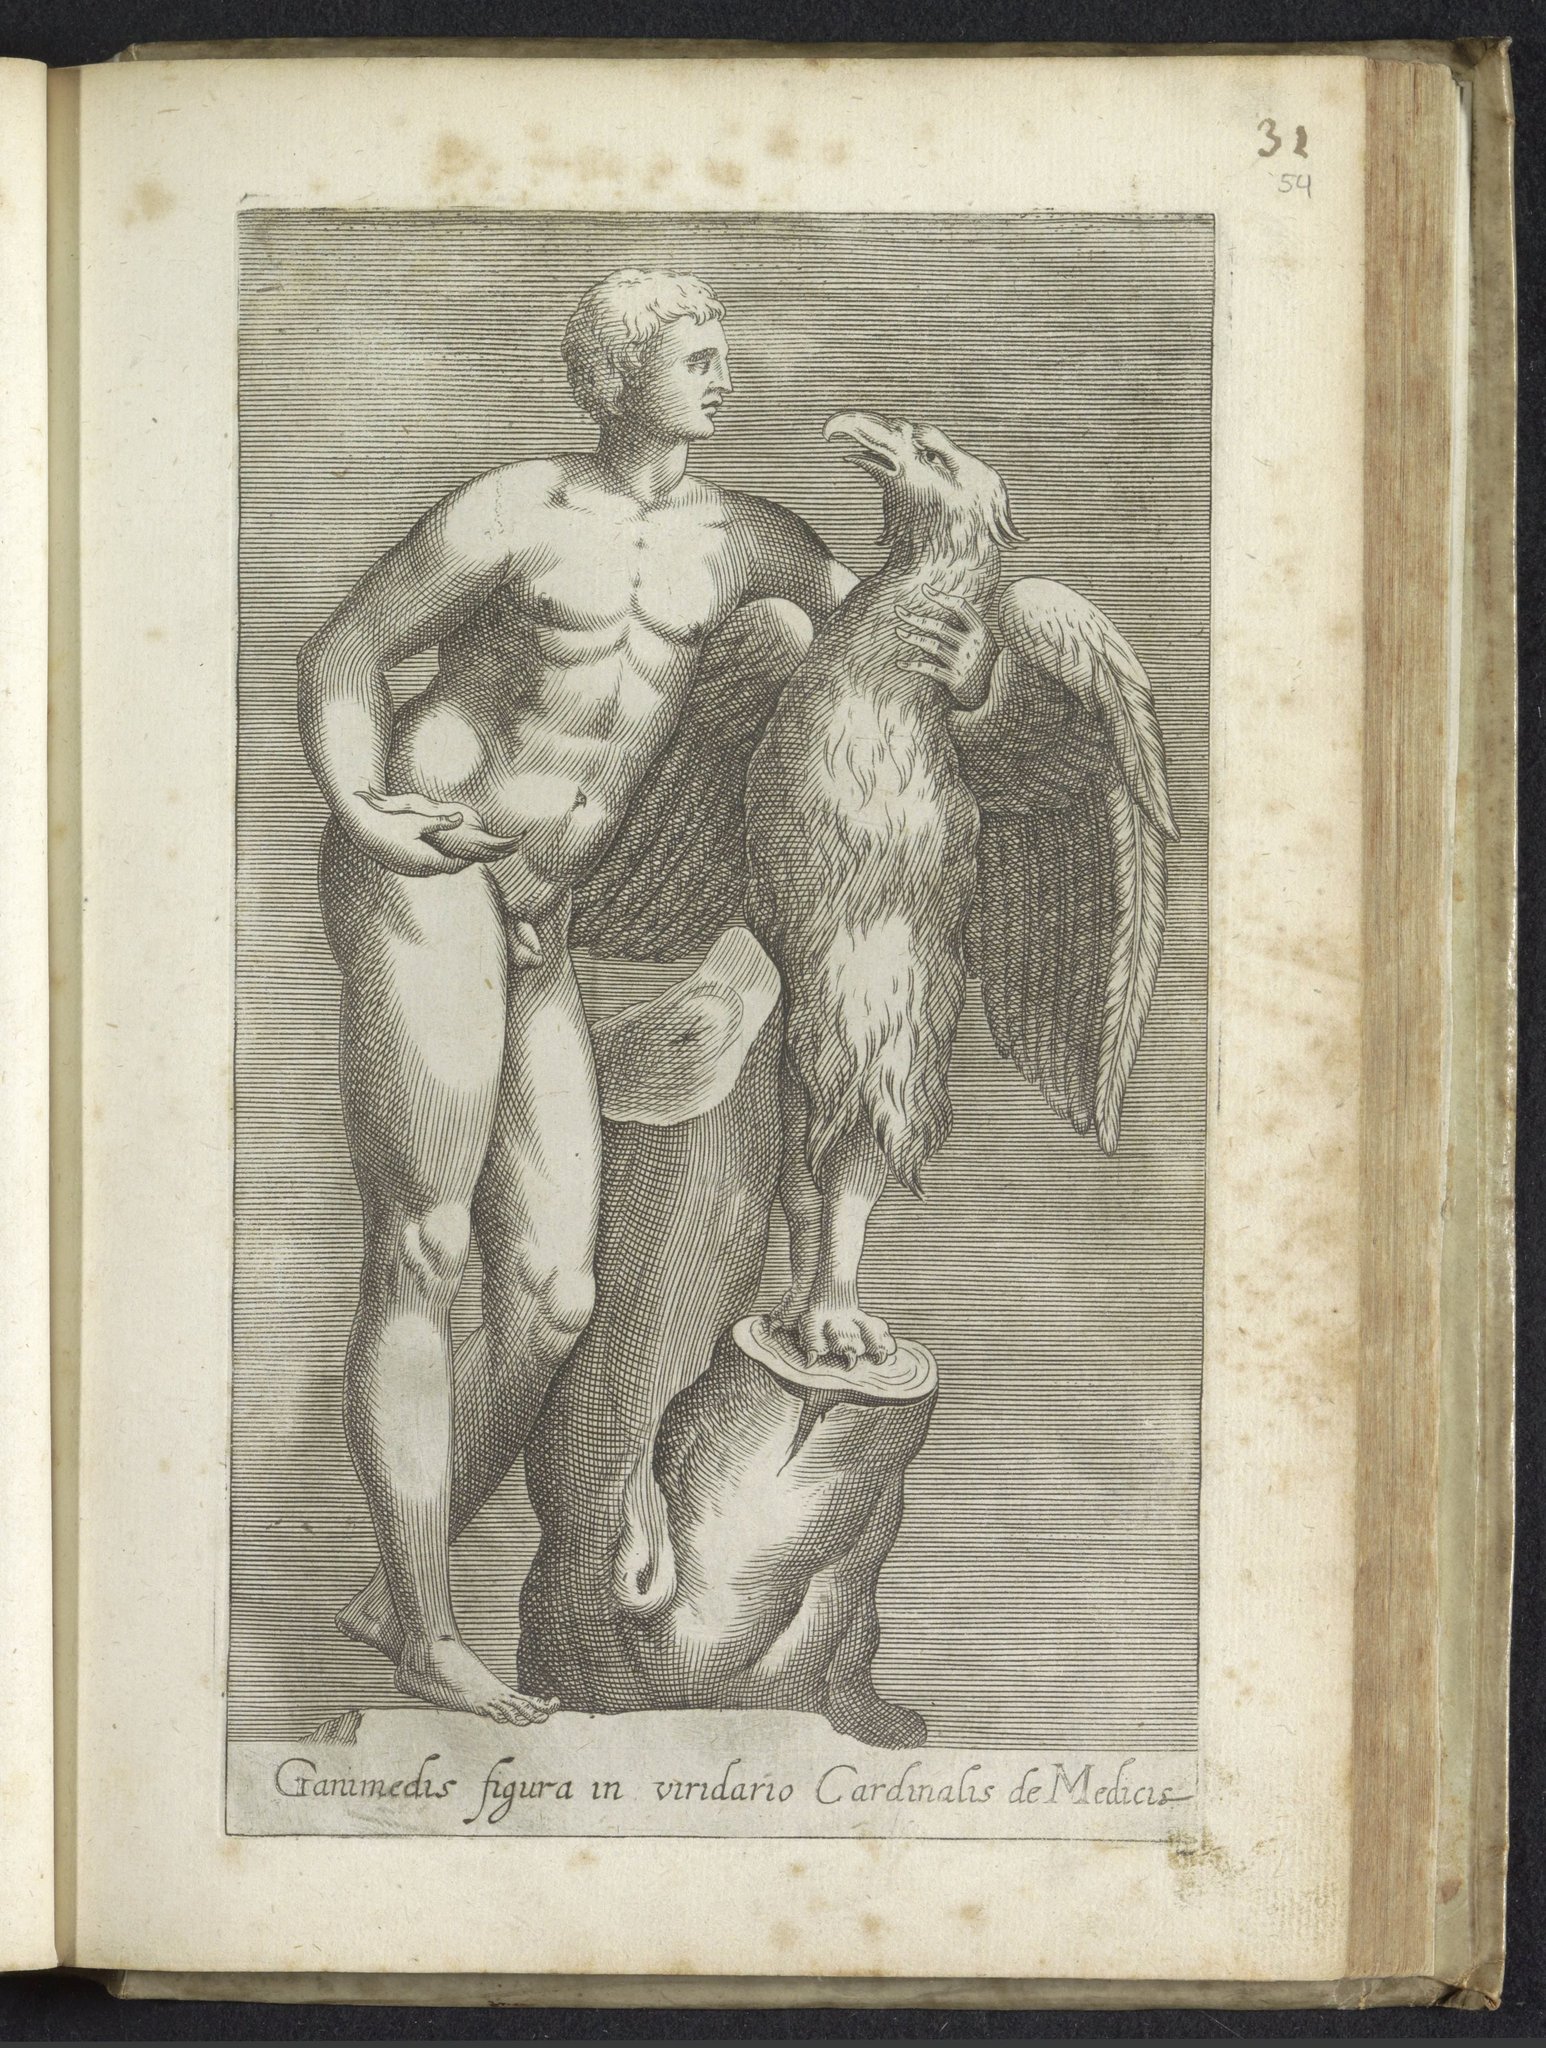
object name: album leaf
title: Ganimedis figura in viridario Cardinalis de Medicis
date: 1584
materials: paper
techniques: engraving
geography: italy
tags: (story of) ganymede, love-affairs of jupiter ~ males, (story of) jupiter (zeus), piece of sculpture, reproduction of a piece of sculpture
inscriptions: number: ‘31’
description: Deze prent maakt deel uit van een set van 79 prenten (+ titelprent) met voorstellingen van antieke sculpturen in Rome.